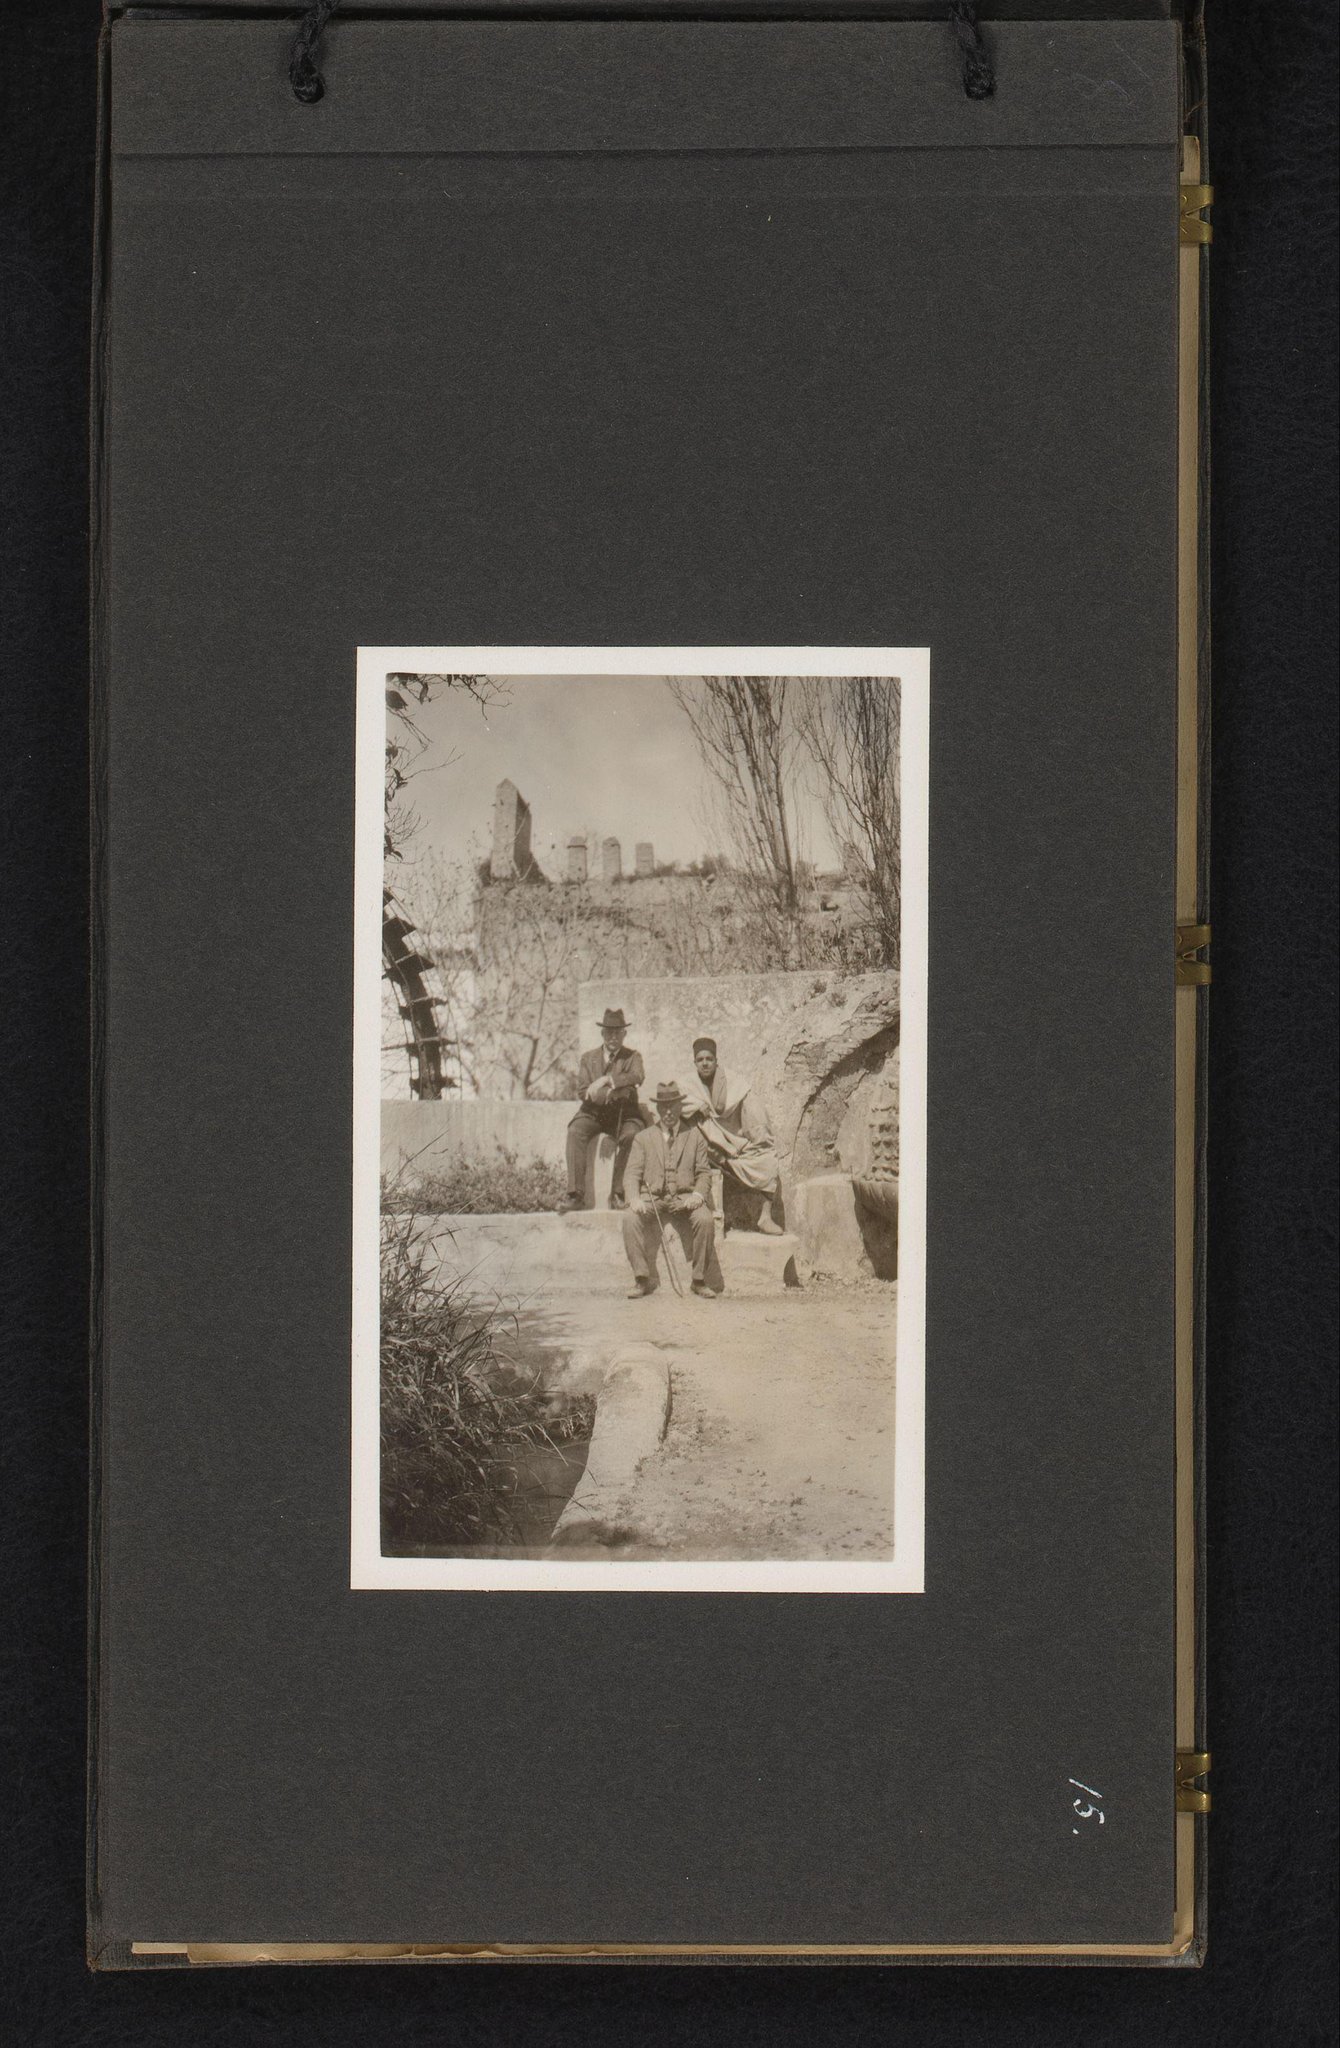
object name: album leaf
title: In den tuin v/d Resident Generaal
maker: a.g.a. van eelde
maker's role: engineer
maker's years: 1862-1950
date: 1927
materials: paper, photographic support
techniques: gelatin silver print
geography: fez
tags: adult man, historical persons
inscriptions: number: ‘15.’